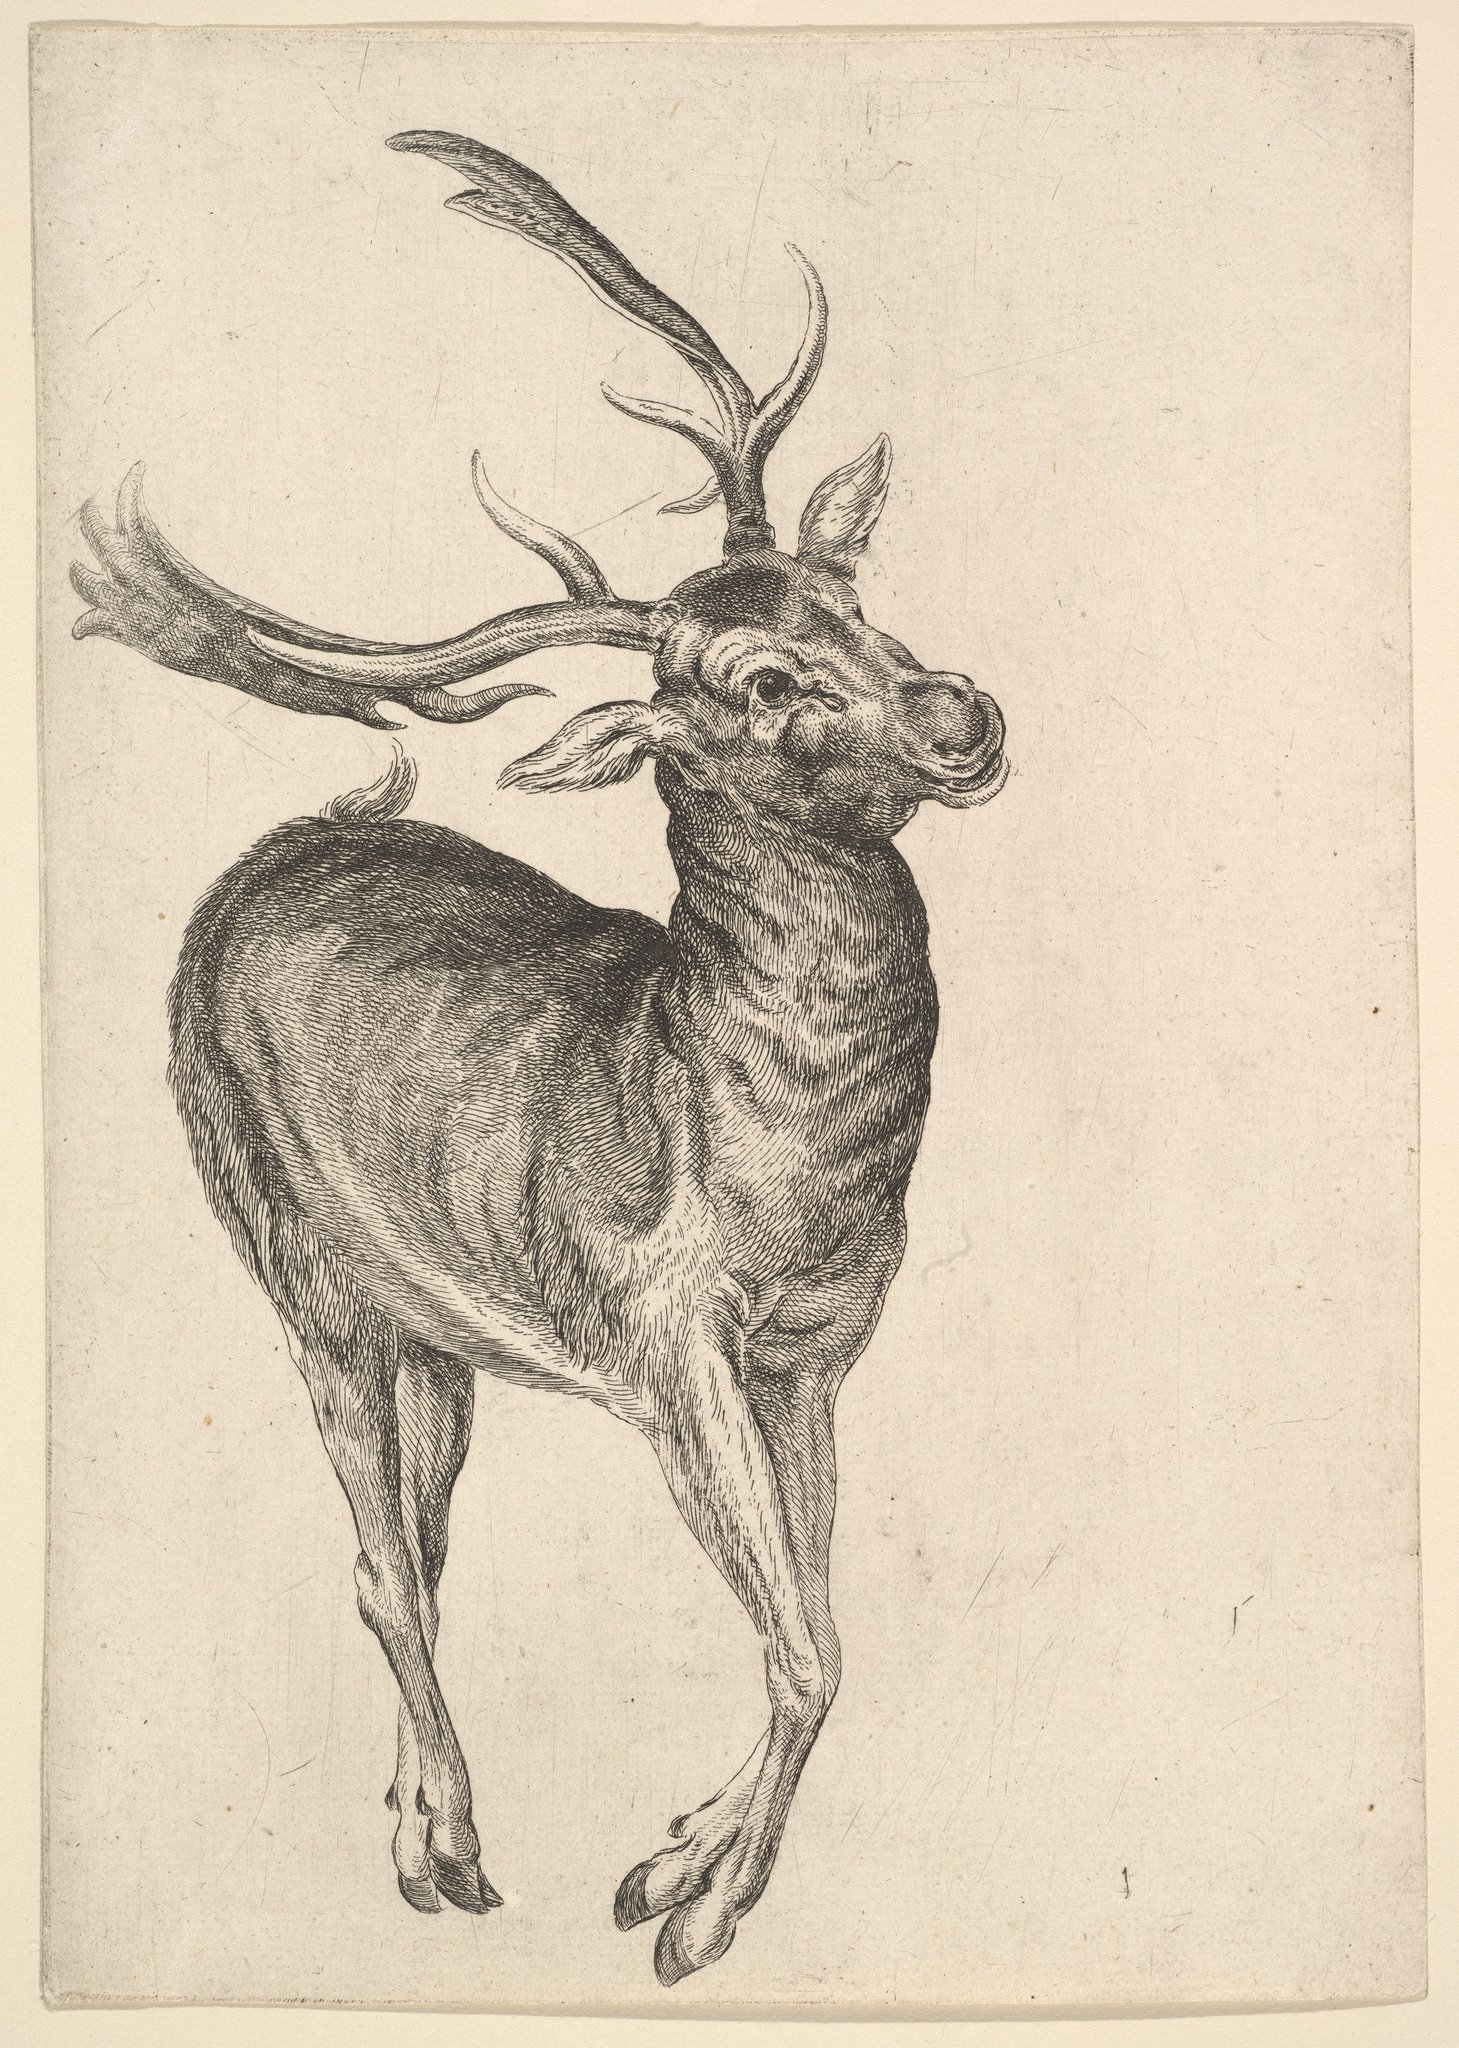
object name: print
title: Stag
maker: wenceslaus hollar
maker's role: artist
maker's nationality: bohemian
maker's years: 1607-1677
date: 1625-1677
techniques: etching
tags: deer